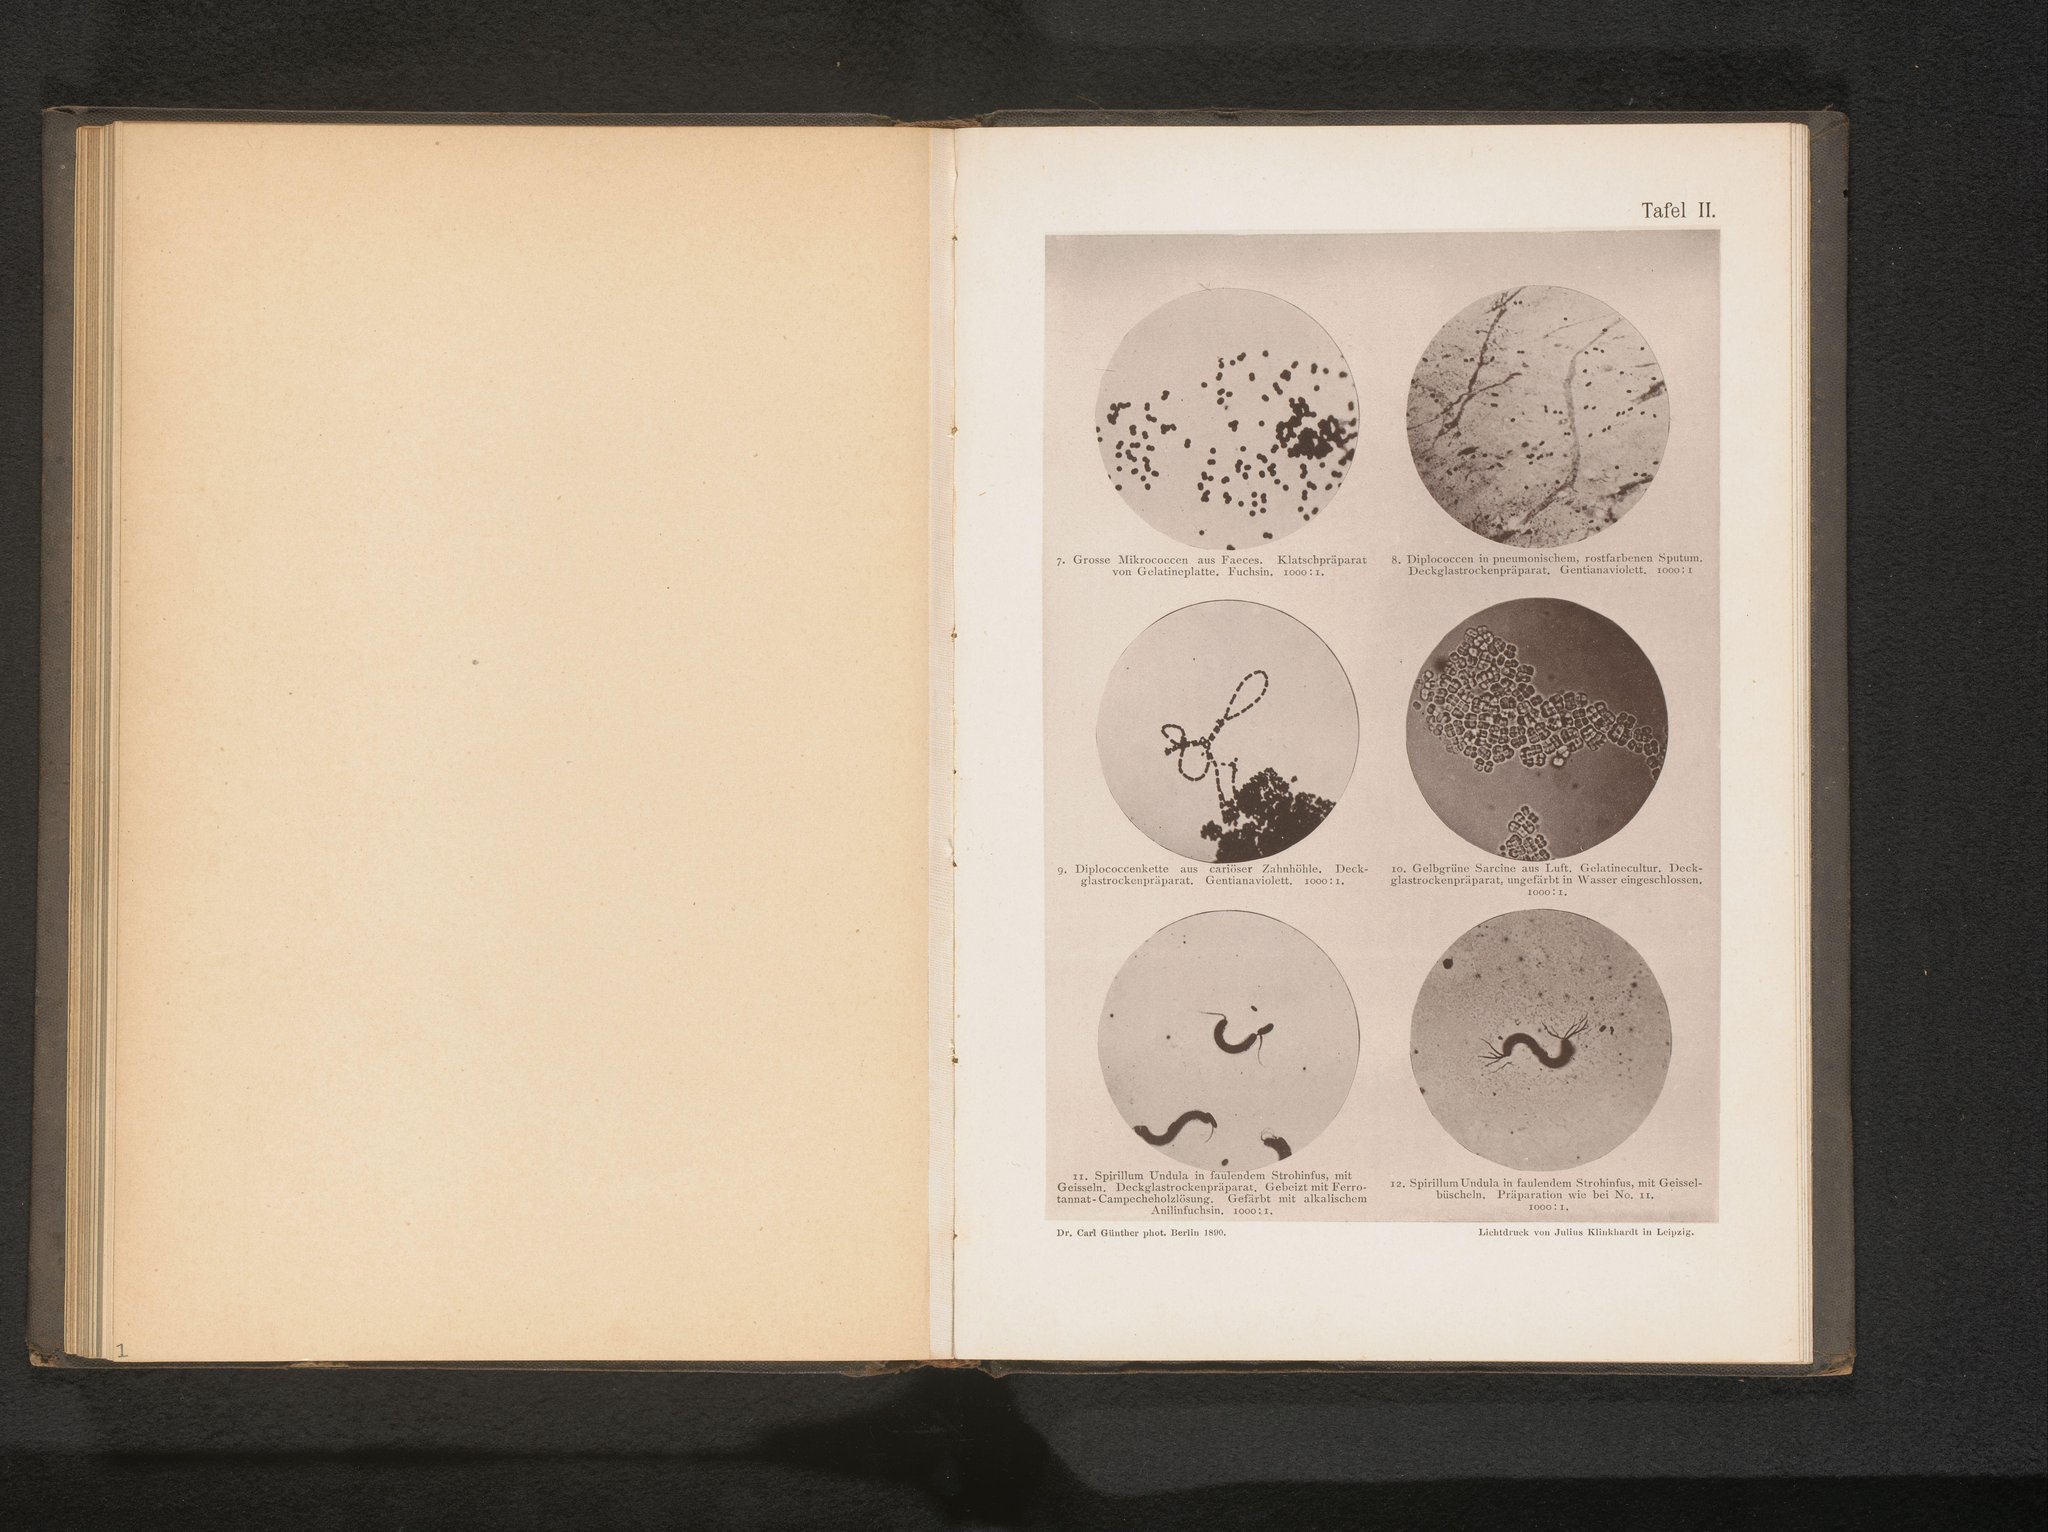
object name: photomechanical print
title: Zes microscoopopnamen van bacteriën en eubacteriën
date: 1880-1890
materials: paper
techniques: photograph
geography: berlin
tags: unicellular animals, bacteria, bacilli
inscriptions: number: ‘Tafel II.’, inscription: ‘7. Grosse Micrococcen aus Faeces. Klatschpräparat von Gelatineplatte. Fuchsin. 1000:1. 8. Diplococcen in pneumonischem, rostfarbenen Sputum. Deckglastrockenpräparat. Gentianaviolett. 1000:1. 9. Diplococcenkette aus cariöser Zahnhöhle. Deckglastrockenpräparat. Gentianaviolett. 1000:1. 10. Gelbgrüne Sarcine aus Luft. Gelatinecultur. Deckglastrockenpräparat, ungefärbt in Wasser eingeschlossen. 1000:1. 11. Spirillum Undula in faulendem Strohinfus, mit Geisseln. Deckglastrockenpräparat. Gebeizt mit Ferrotannat-Campecheholzlösung. Gefärbt mit alkalischem Anilinfuchsin. 1000:1. 12. Spirillum Undula in faulendem Strohinfus, mit Gessel-büscheln. Präparation wie bei No. 11. 100:1.’